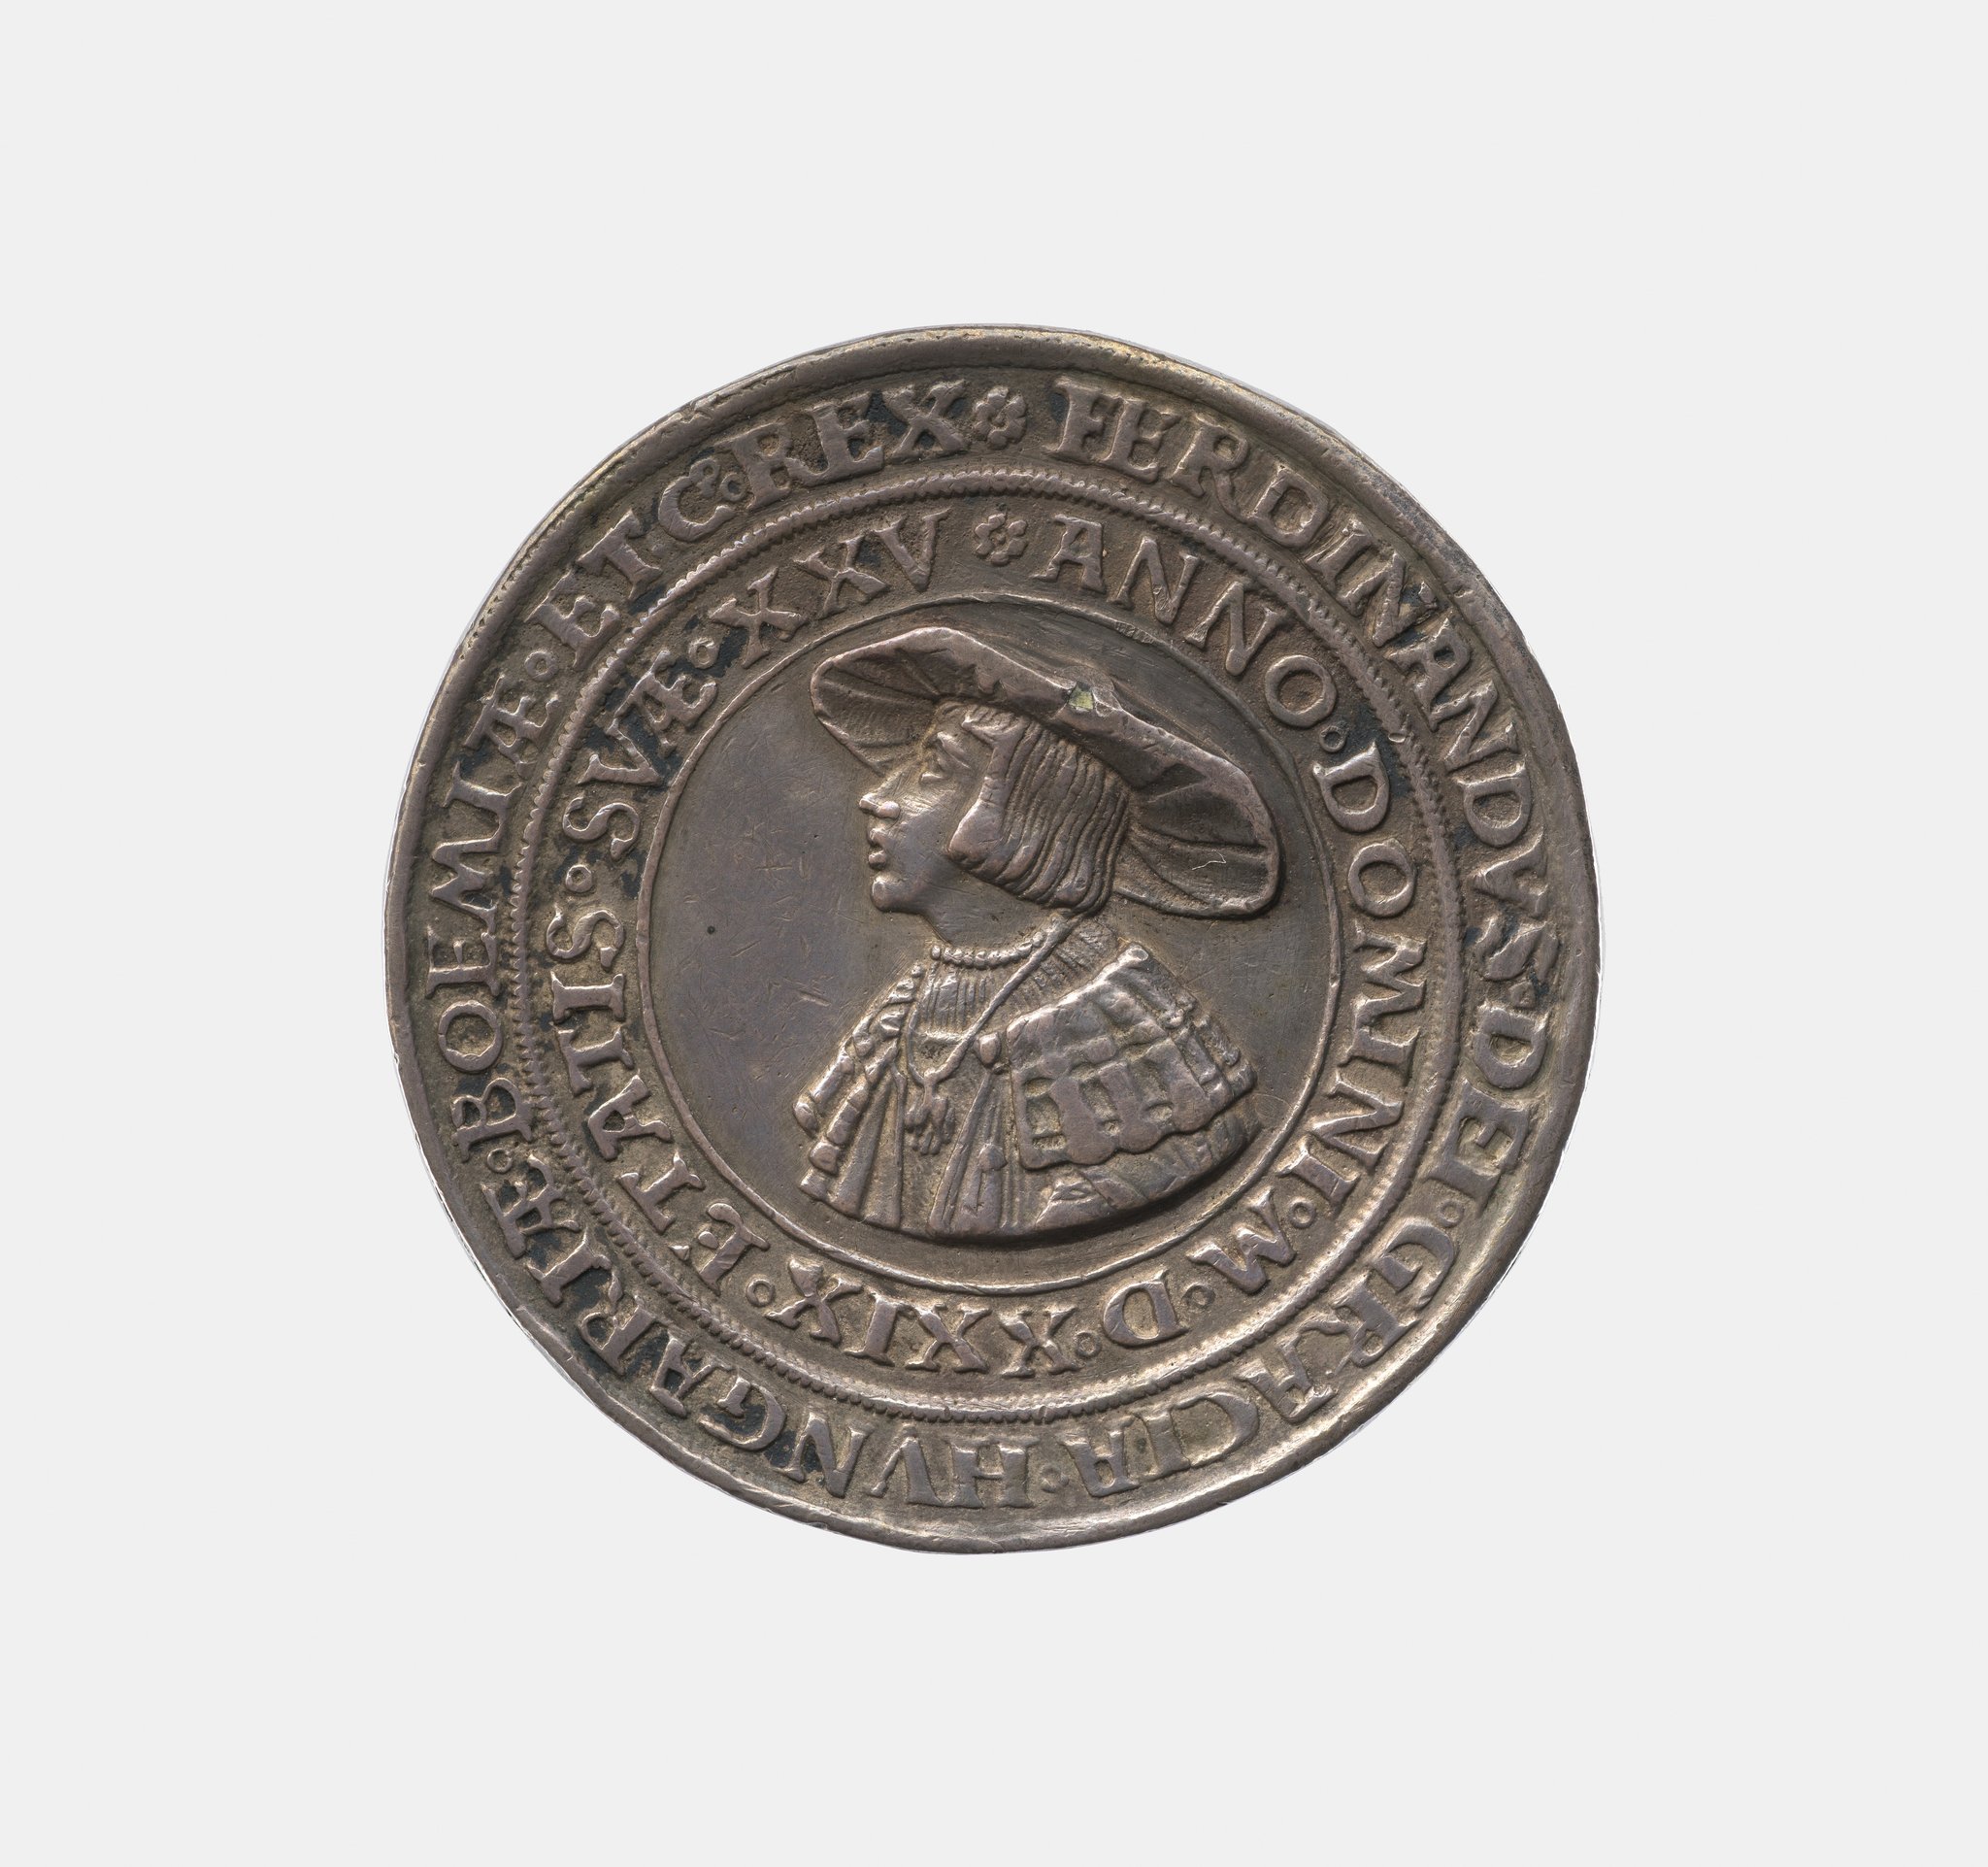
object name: thaler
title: One and one-half thaler (schanstück?) of Ferdinand I (1503-1564) as King of Hungary, Croatia and Bohemia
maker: hieronymus magdeburger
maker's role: artist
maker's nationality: german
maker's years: 1507-1540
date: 1529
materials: silver